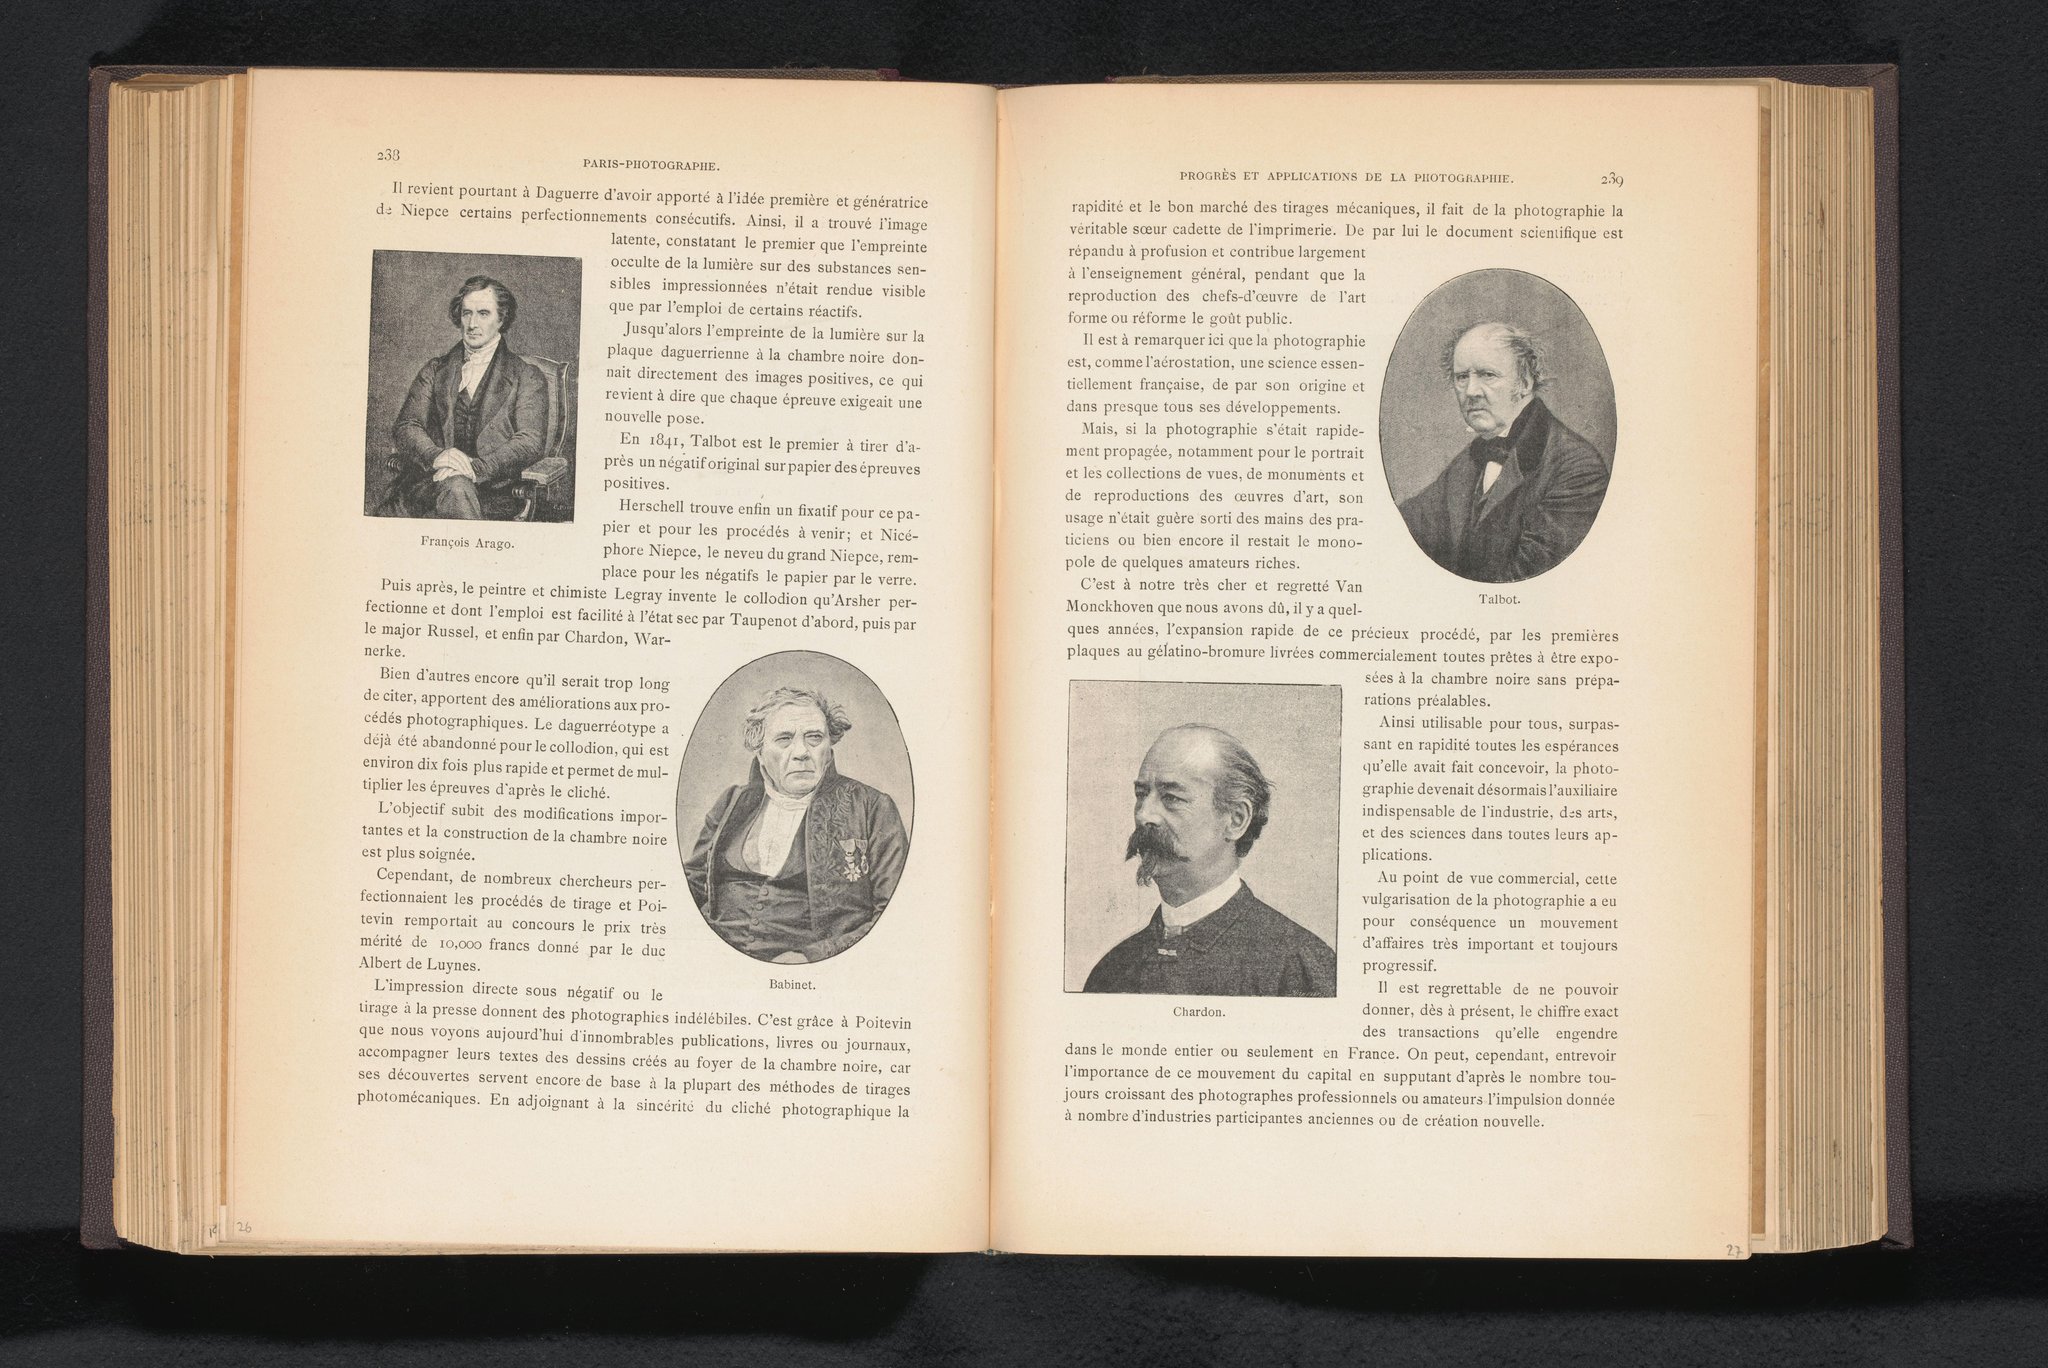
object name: page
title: Talbot. Chardon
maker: Anonymous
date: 1850-1880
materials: paper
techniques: autotype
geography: france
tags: printer, alfred le jeune chardon, william henry fox talbot, adult man, photographer in non-work situation